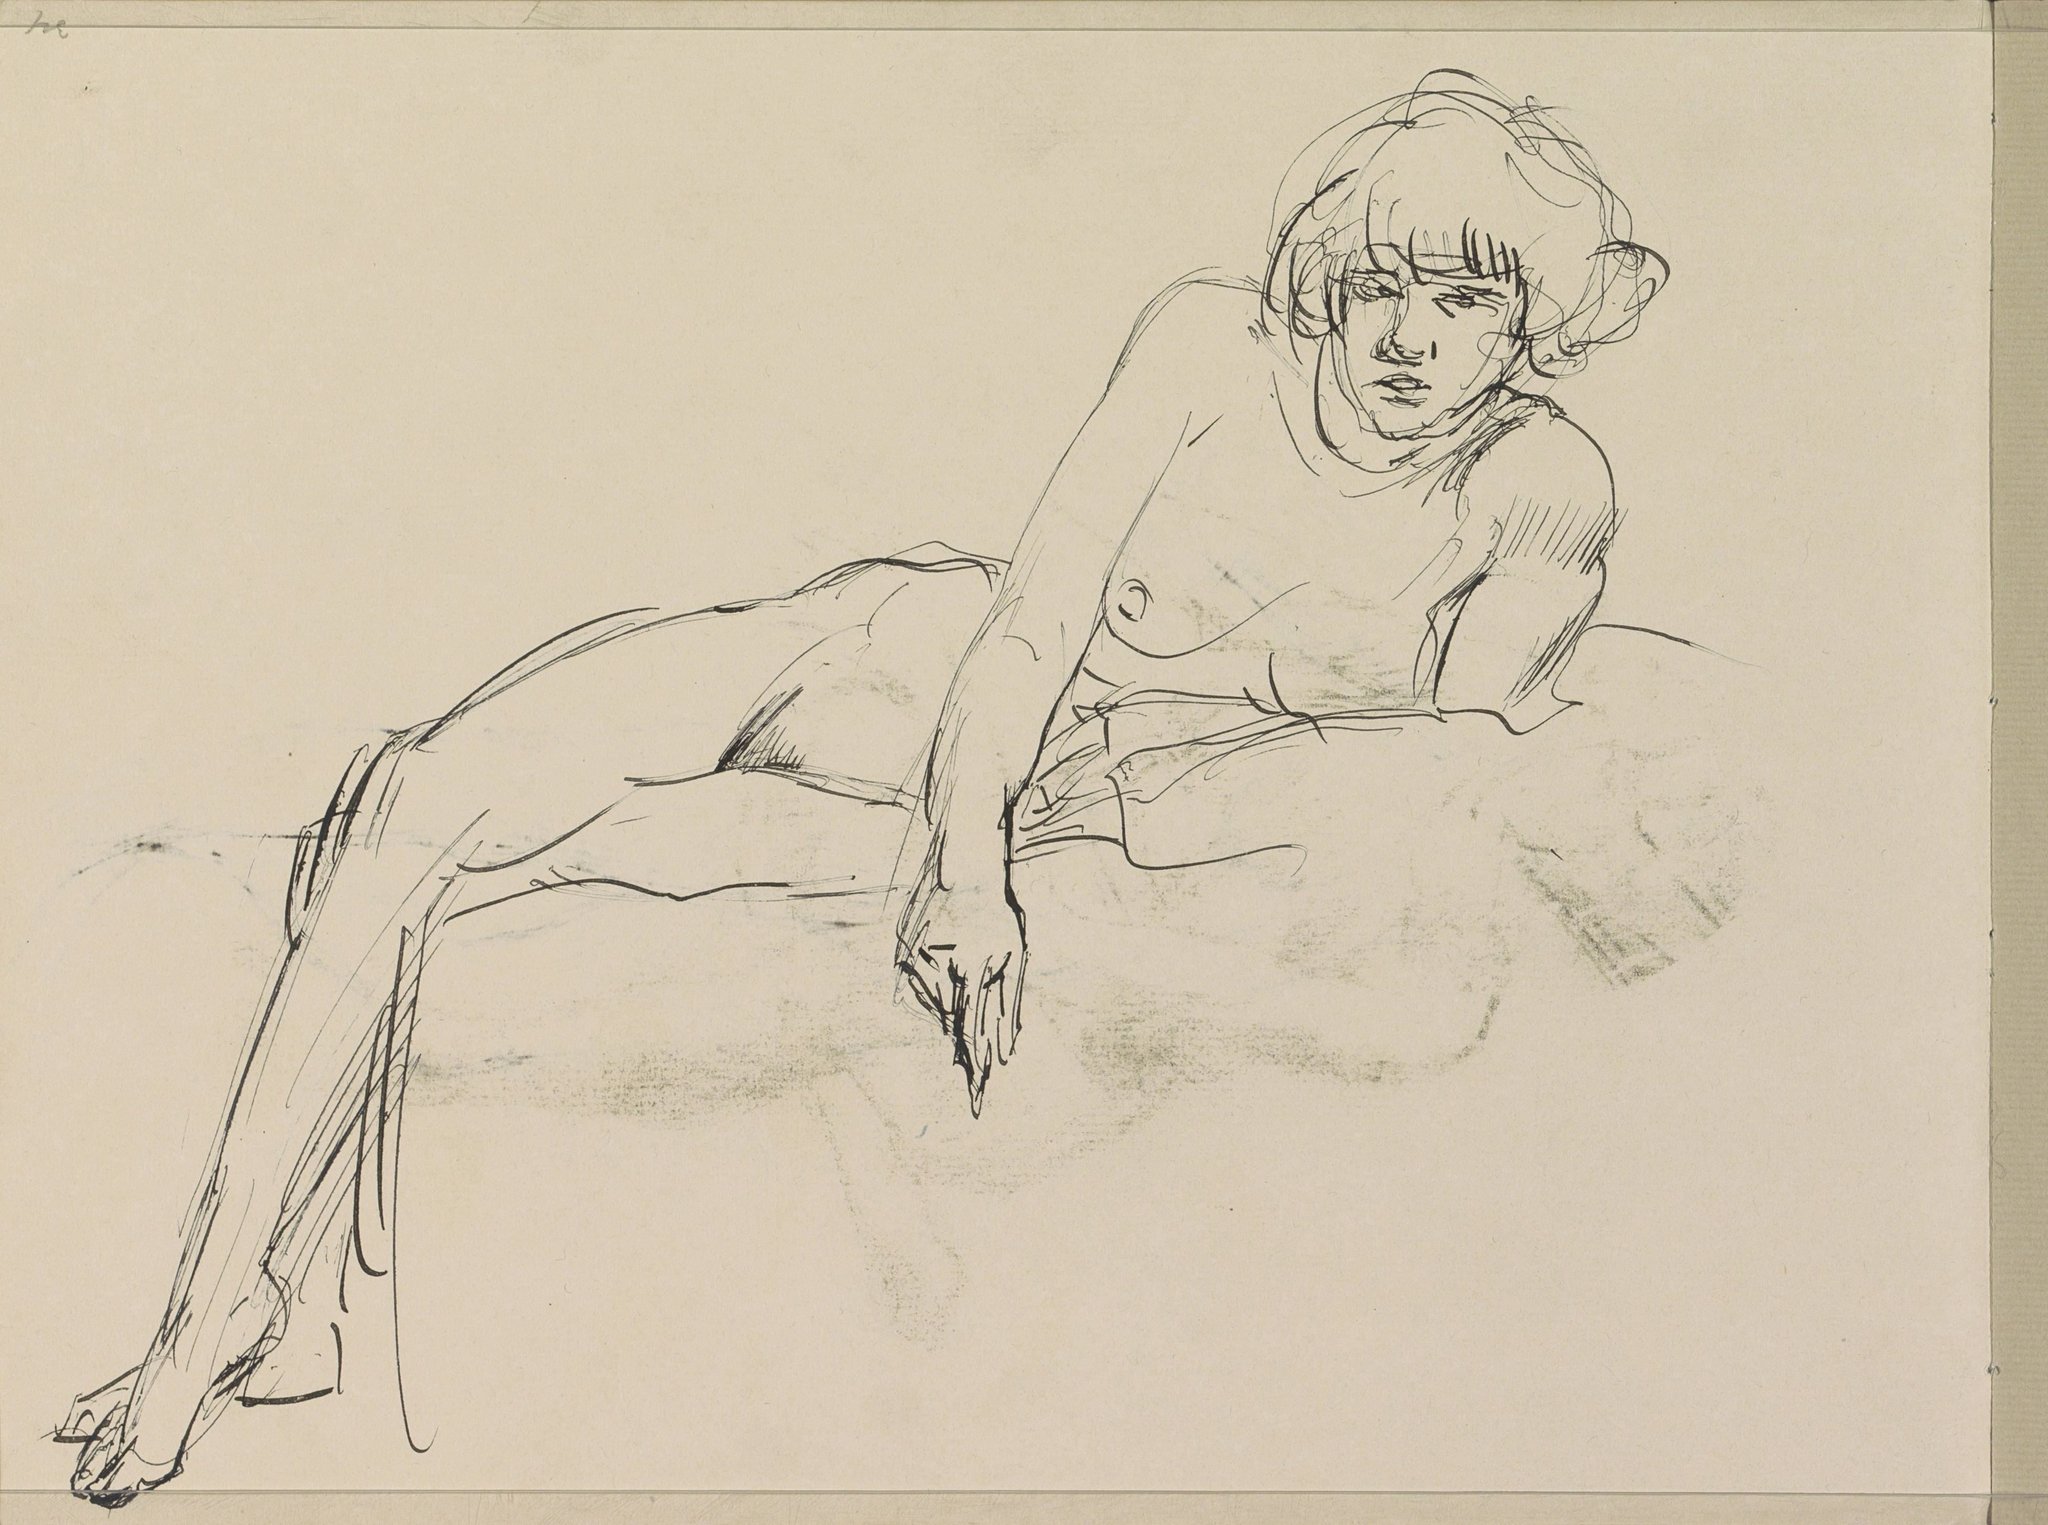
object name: sketchbook leaf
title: Reclining Female Nude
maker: isaac israels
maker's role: draughtsman, painter, print maker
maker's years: 1865-1934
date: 1875-1934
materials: ink, paper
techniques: pen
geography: the hague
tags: lying on one side, with uplifted upper part of the body and leaning on the arm - aa - female human figure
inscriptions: watermark: ‘Holland’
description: Ze leunt op een arm. Blad 21 verso uit schetsboek IV met 27 bladen.